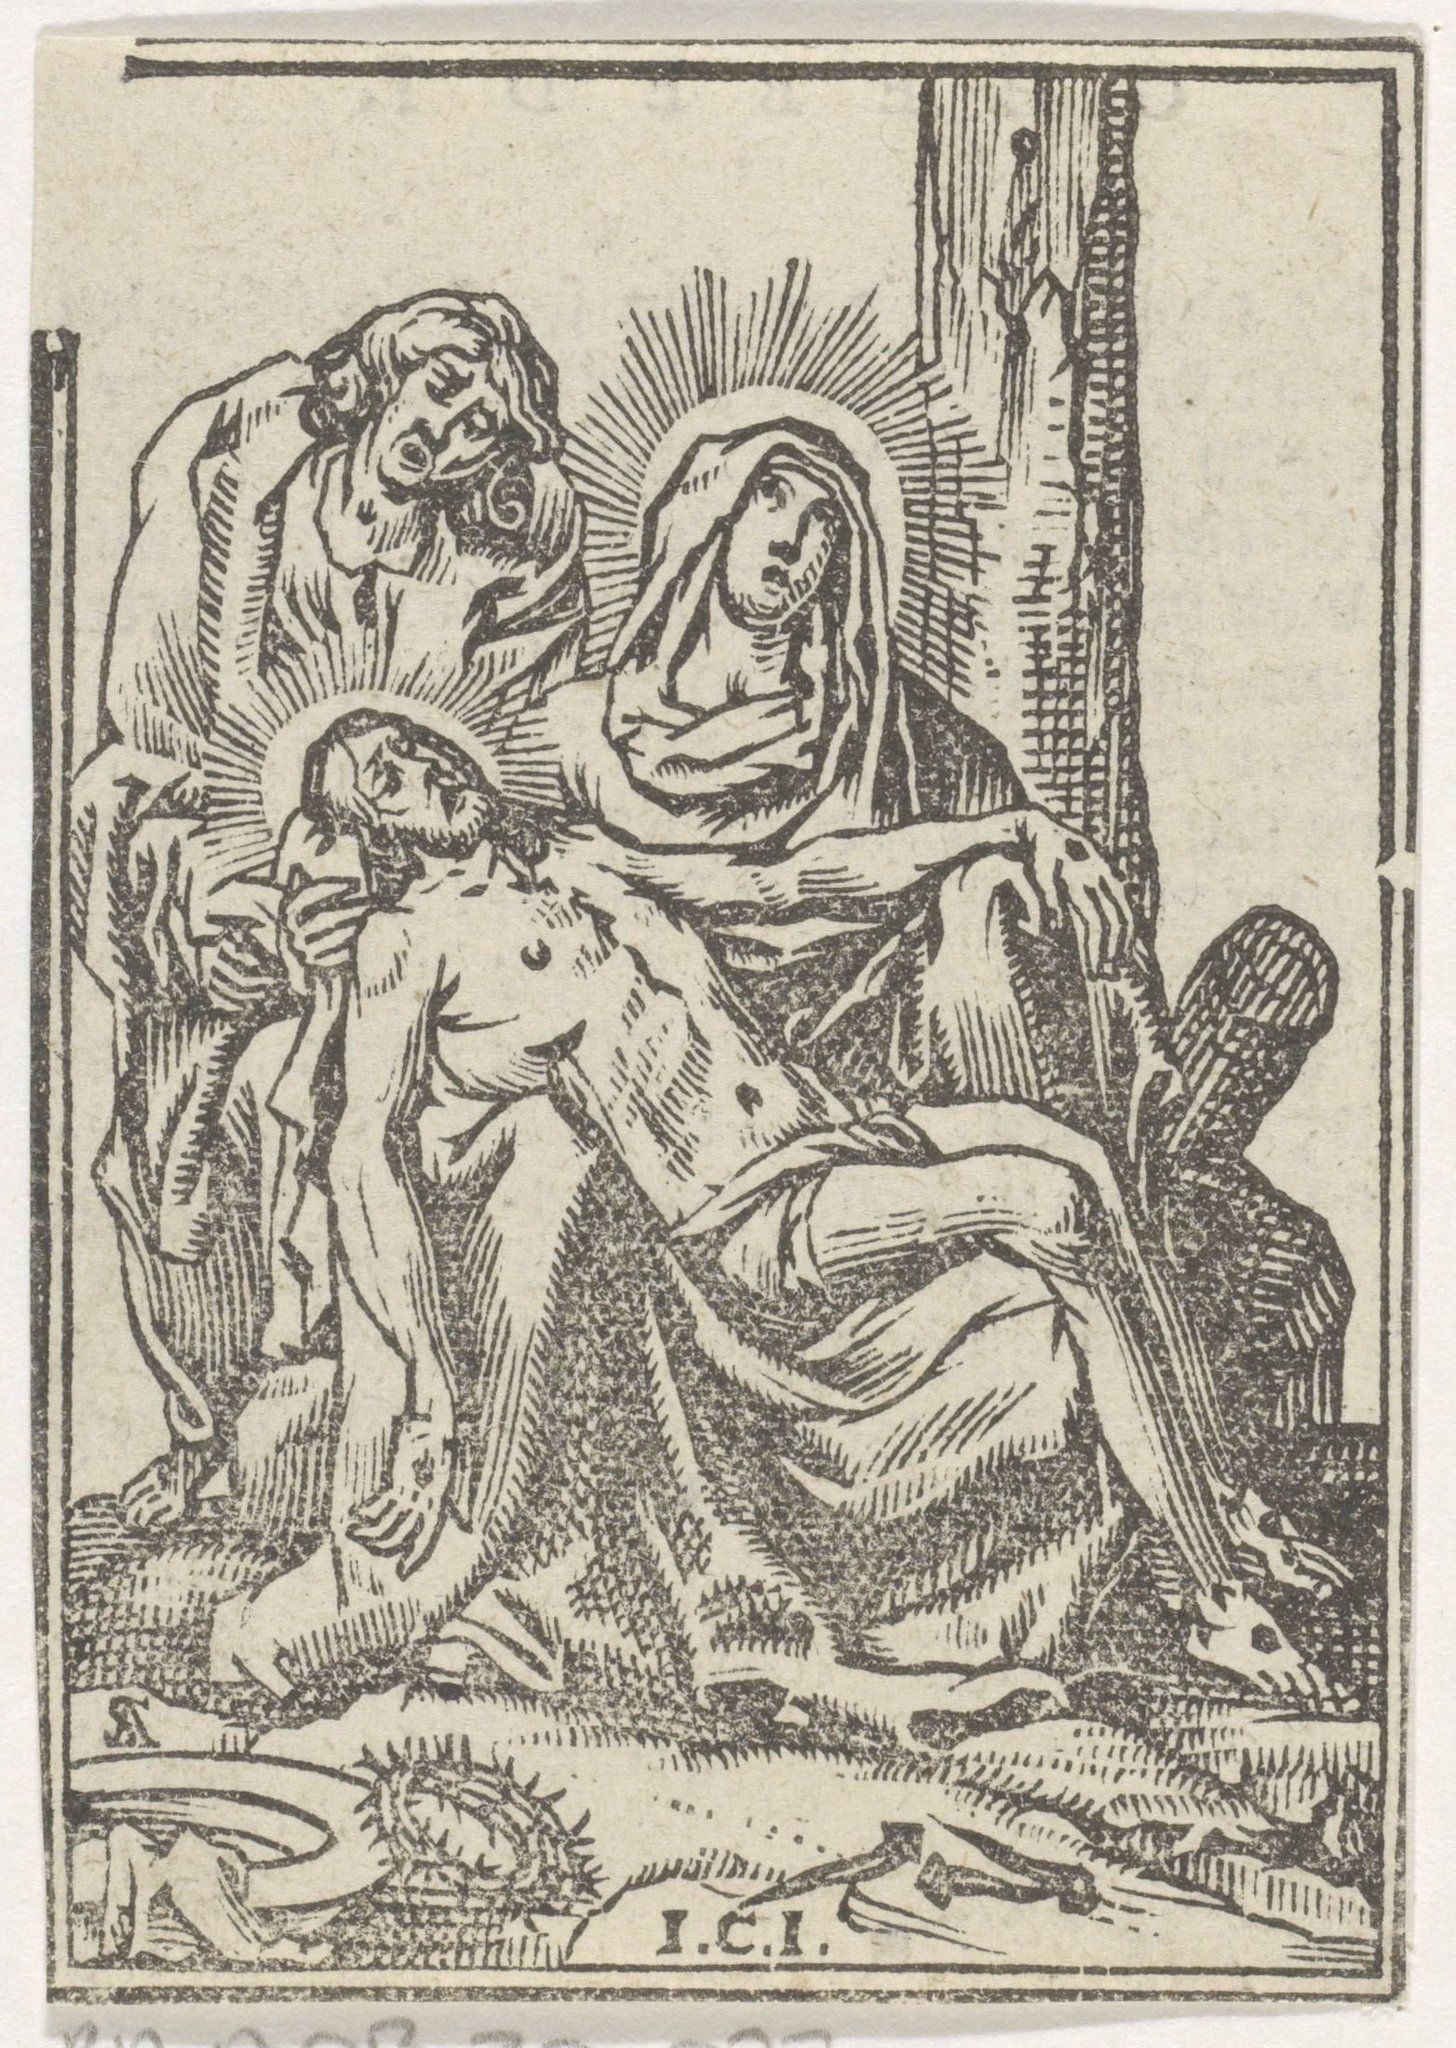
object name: book illustration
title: Piëta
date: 1649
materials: paper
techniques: letterpress printing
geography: antwerp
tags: the dead christ in mary's lap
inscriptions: collector's mark: Lugt 2228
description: Maria treurt aan de voet van het kruis met het lichaam van de gestorven Christus in haar schoot. Naast haar staat Johannes.